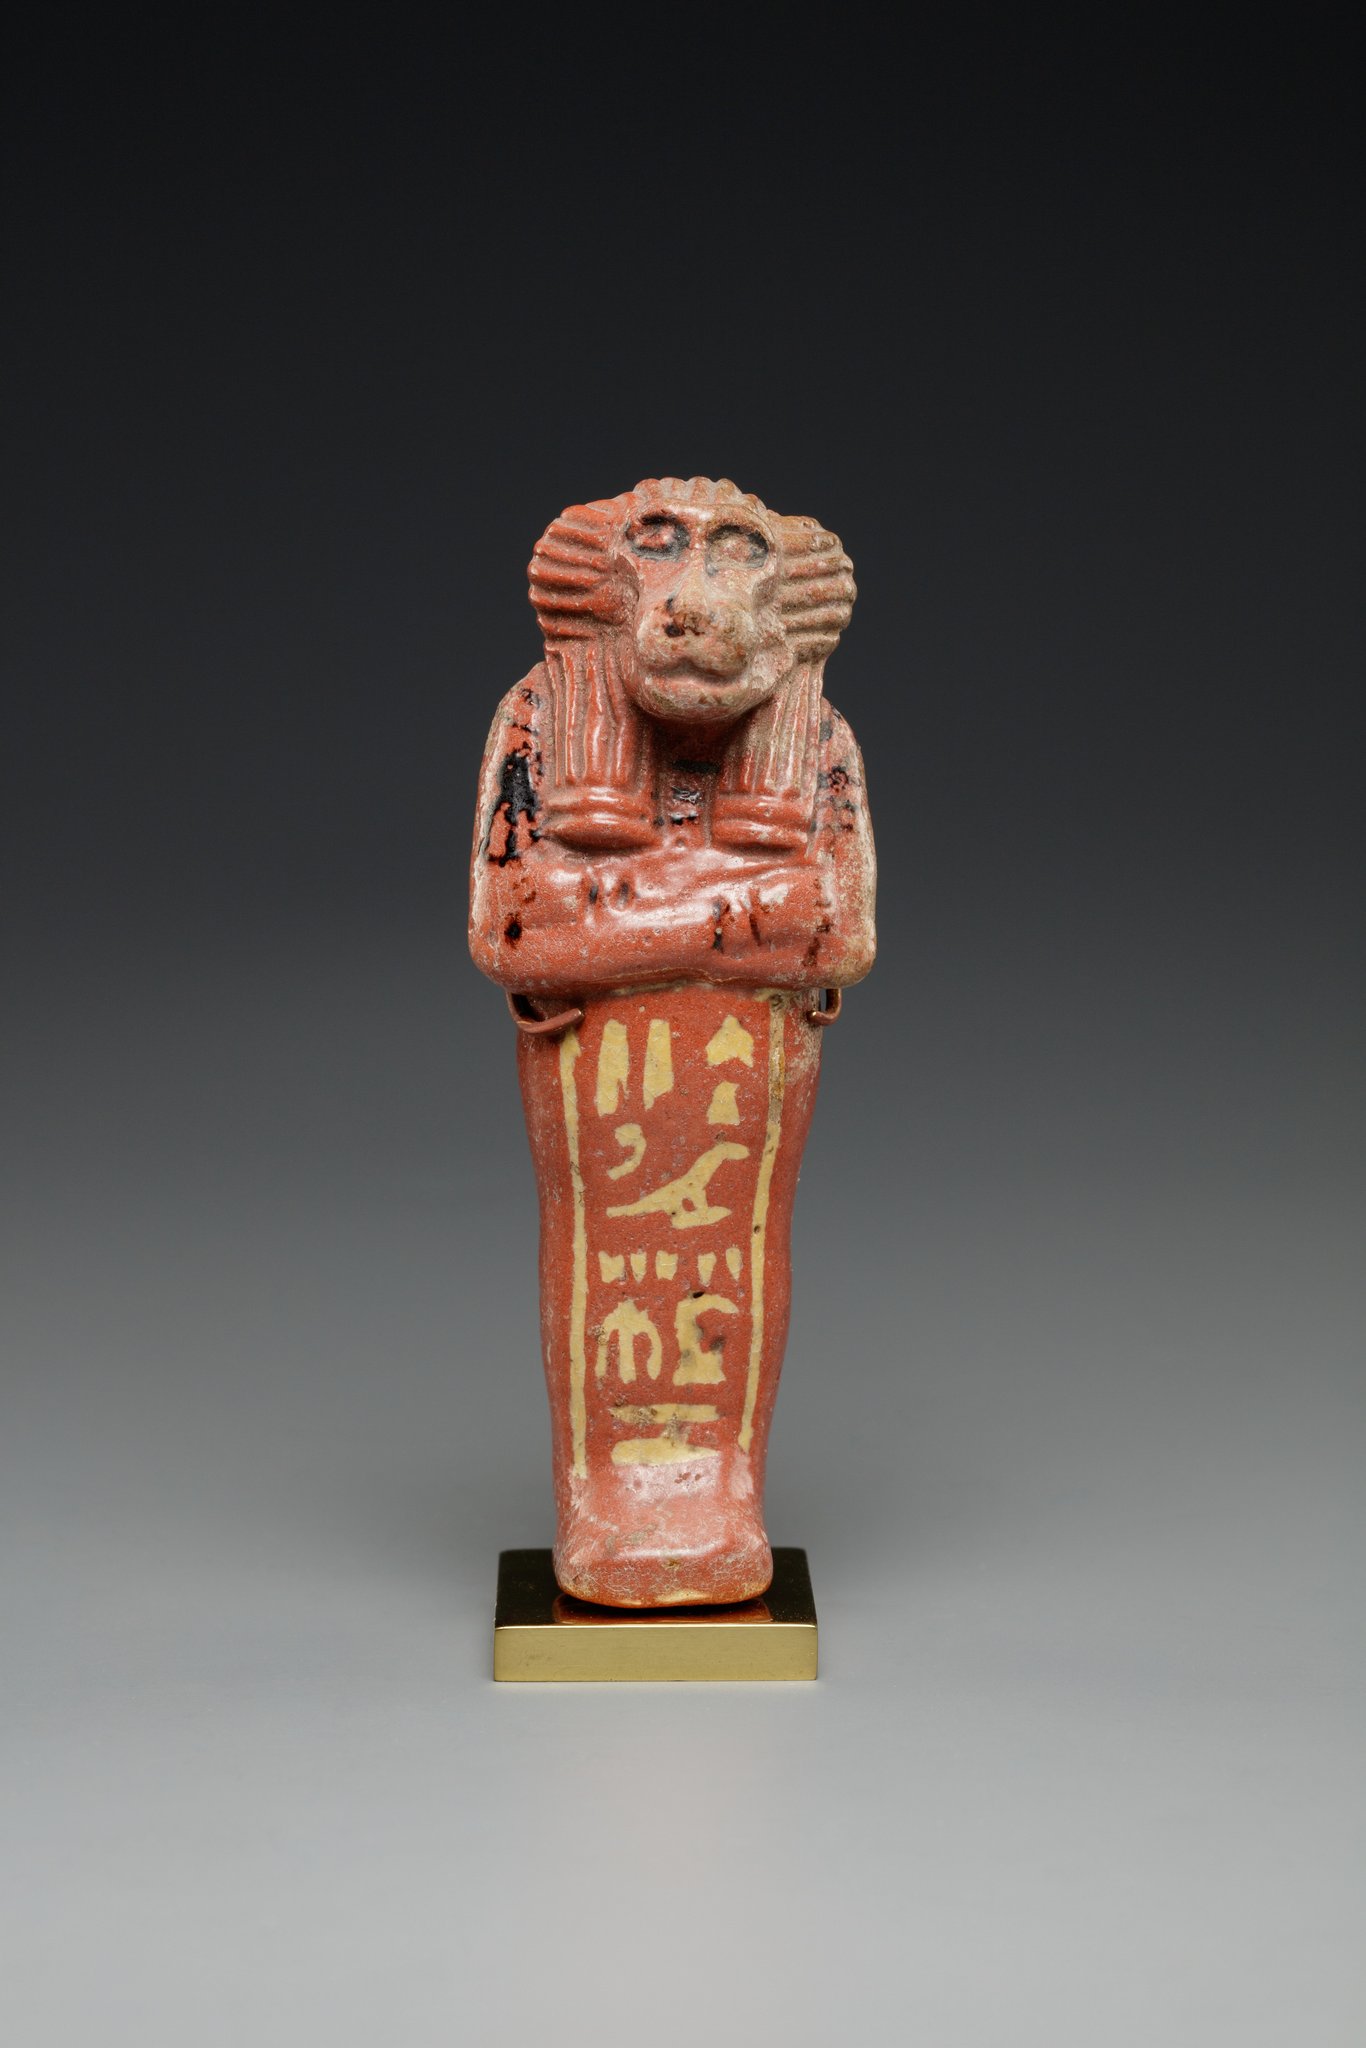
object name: hapy, son of horus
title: Figure of Hapy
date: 1295-1185 BCE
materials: faience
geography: egypt